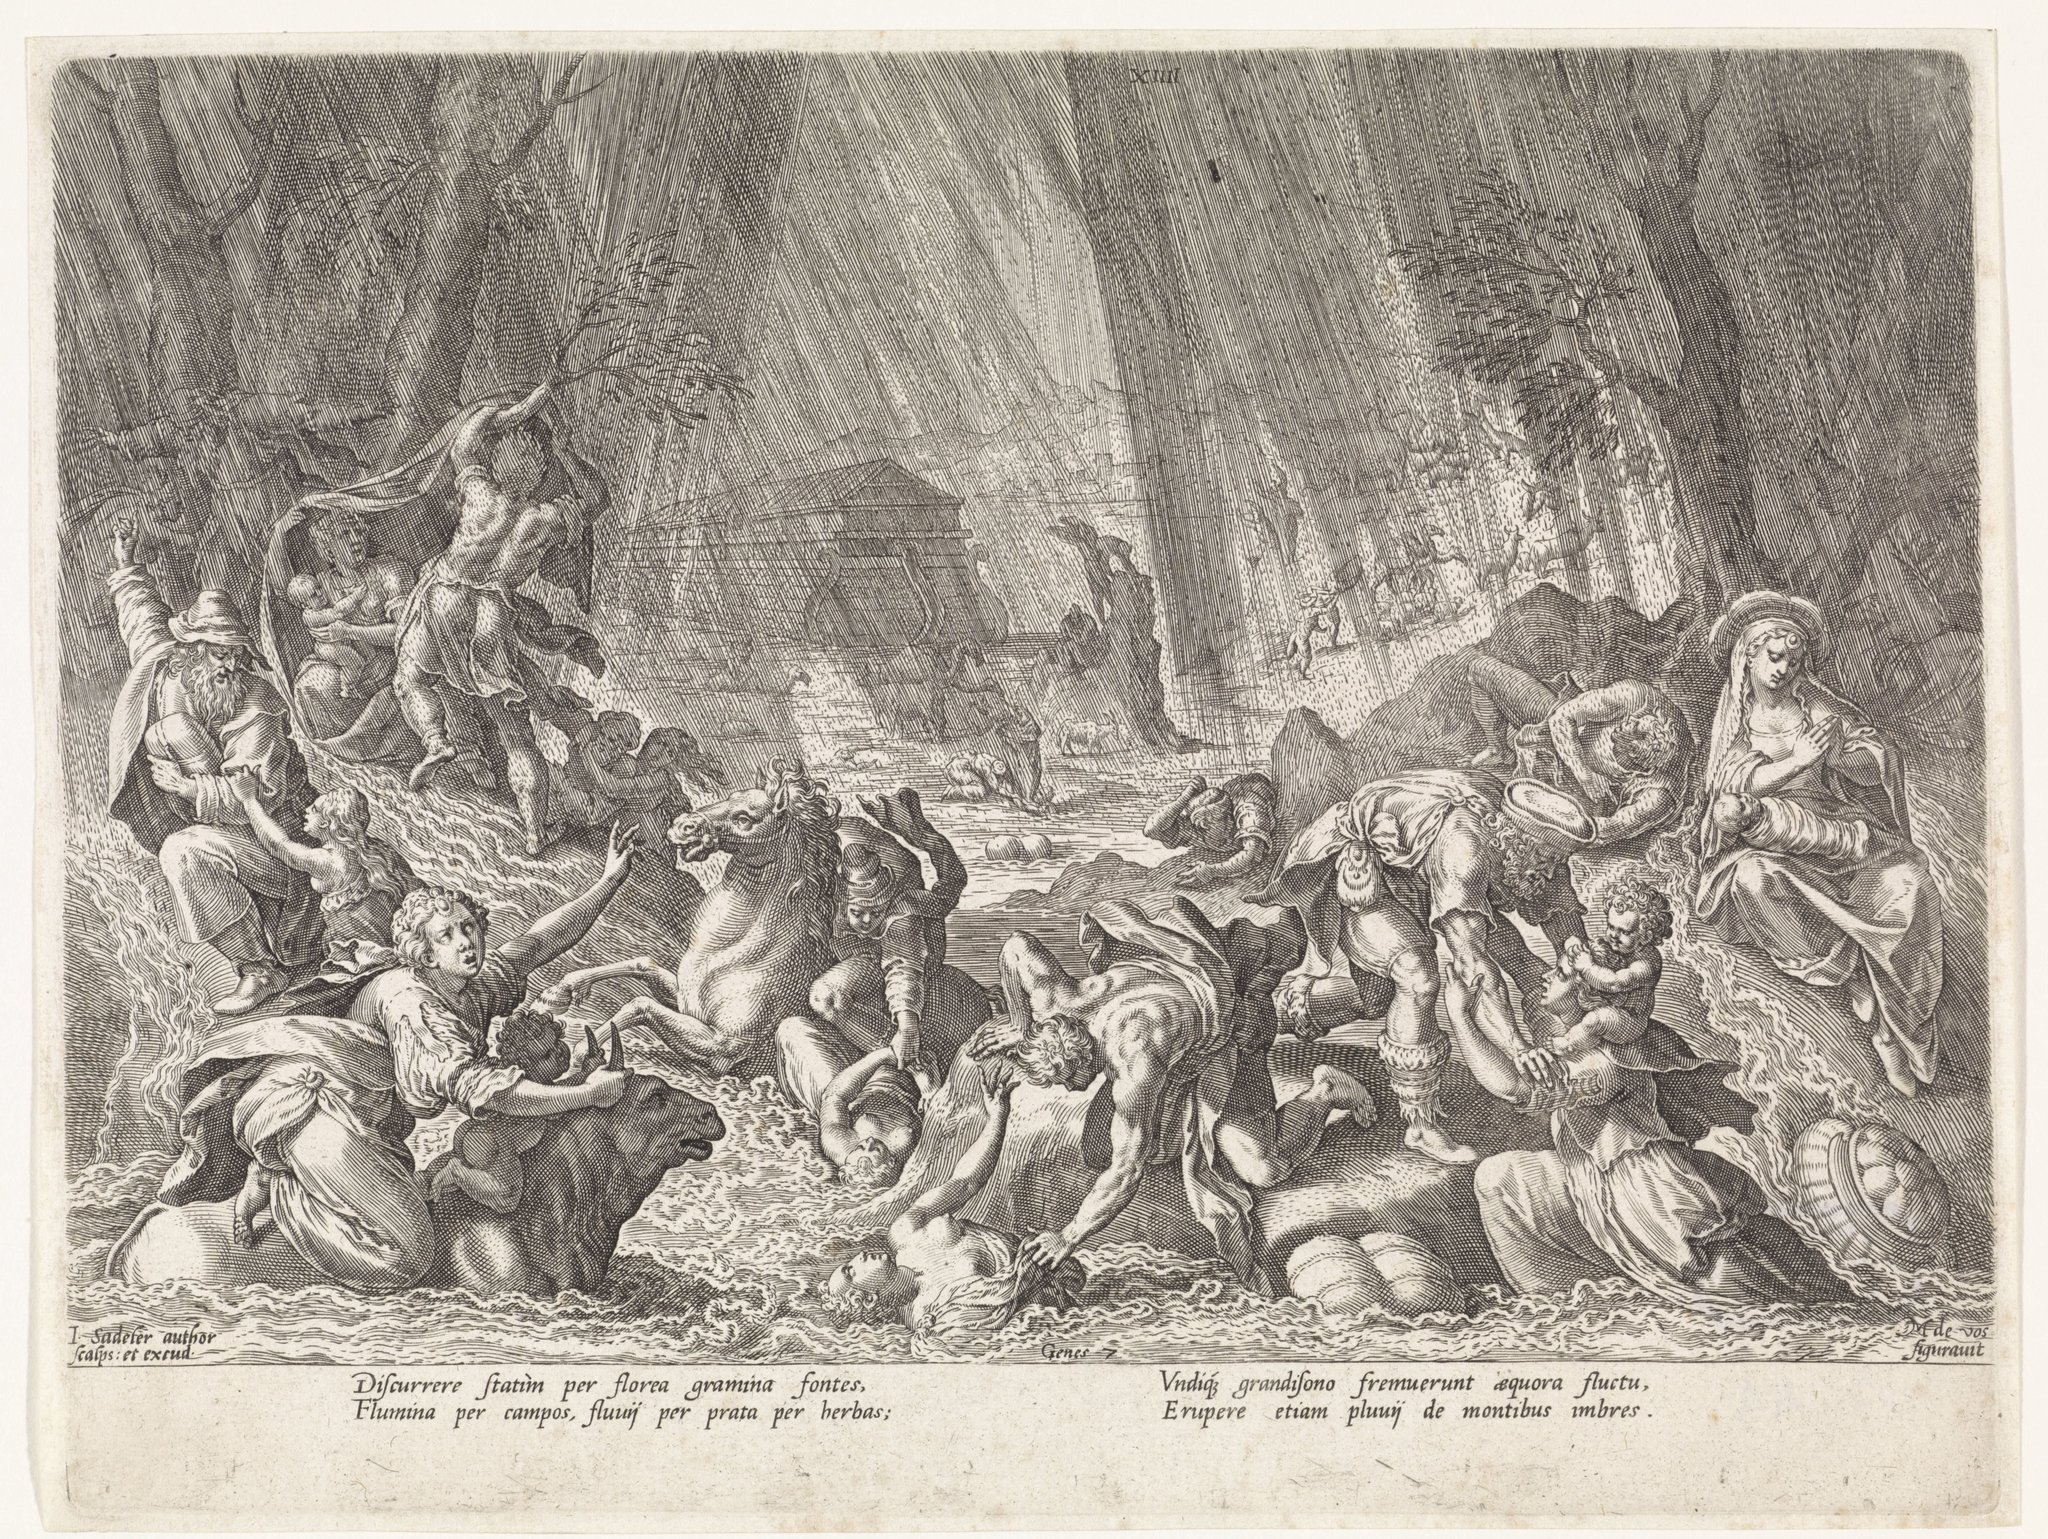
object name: print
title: Bonorum et Malorum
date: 1586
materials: paper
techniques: engraving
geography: antwerp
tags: the ark is floating on the waters, while life on earth is destroyed ~ story of noah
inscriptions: collector's mark: Lugt 11, collector's mark: Lugt 10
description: Het begin van de zondvloed. Het regent en op de voorgrond proberen mensen zich te redden door zich op hoger gelegen land te begeven. Anderen verdrinken. Op de achtergrond de ark van Noach. De prent heeft een Latijns onderschrift.